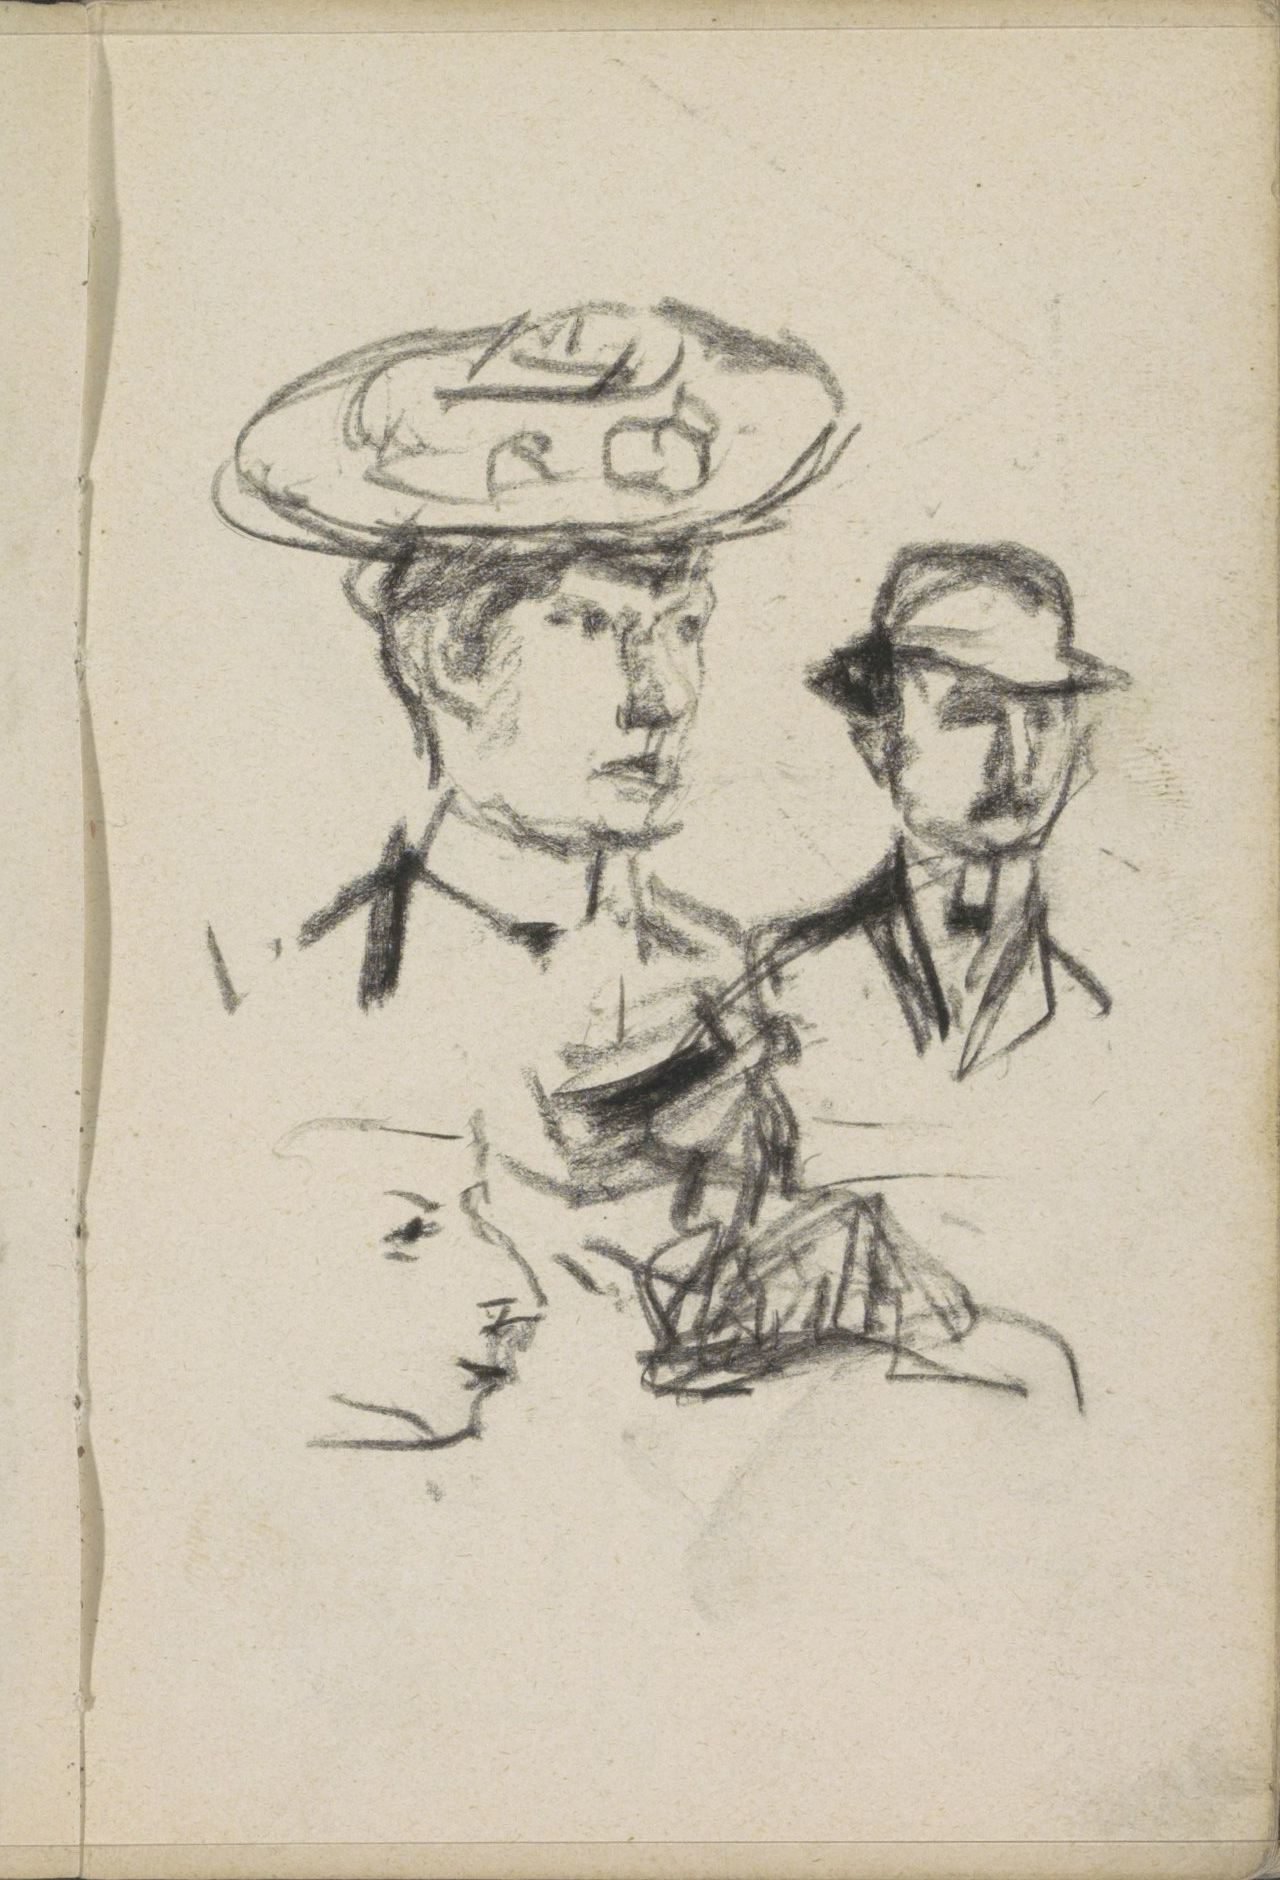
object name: sketchbook leaf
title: Figuurstudies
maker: george hendrik breitner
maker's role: draughtsman, painter, print maker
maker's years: 1857-1923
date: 1900-1923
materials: chalk, paper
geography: amsterdam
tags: head (human), head-gear: hat (+ women's clothes), head (human) - aa - female human figure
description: Vrouwenhoofd met hoed, mannenhoofd met hoed en een mannenhoofd in profiel naar rechts. Pagina 4 uit een schetsboek met 39 bladen.